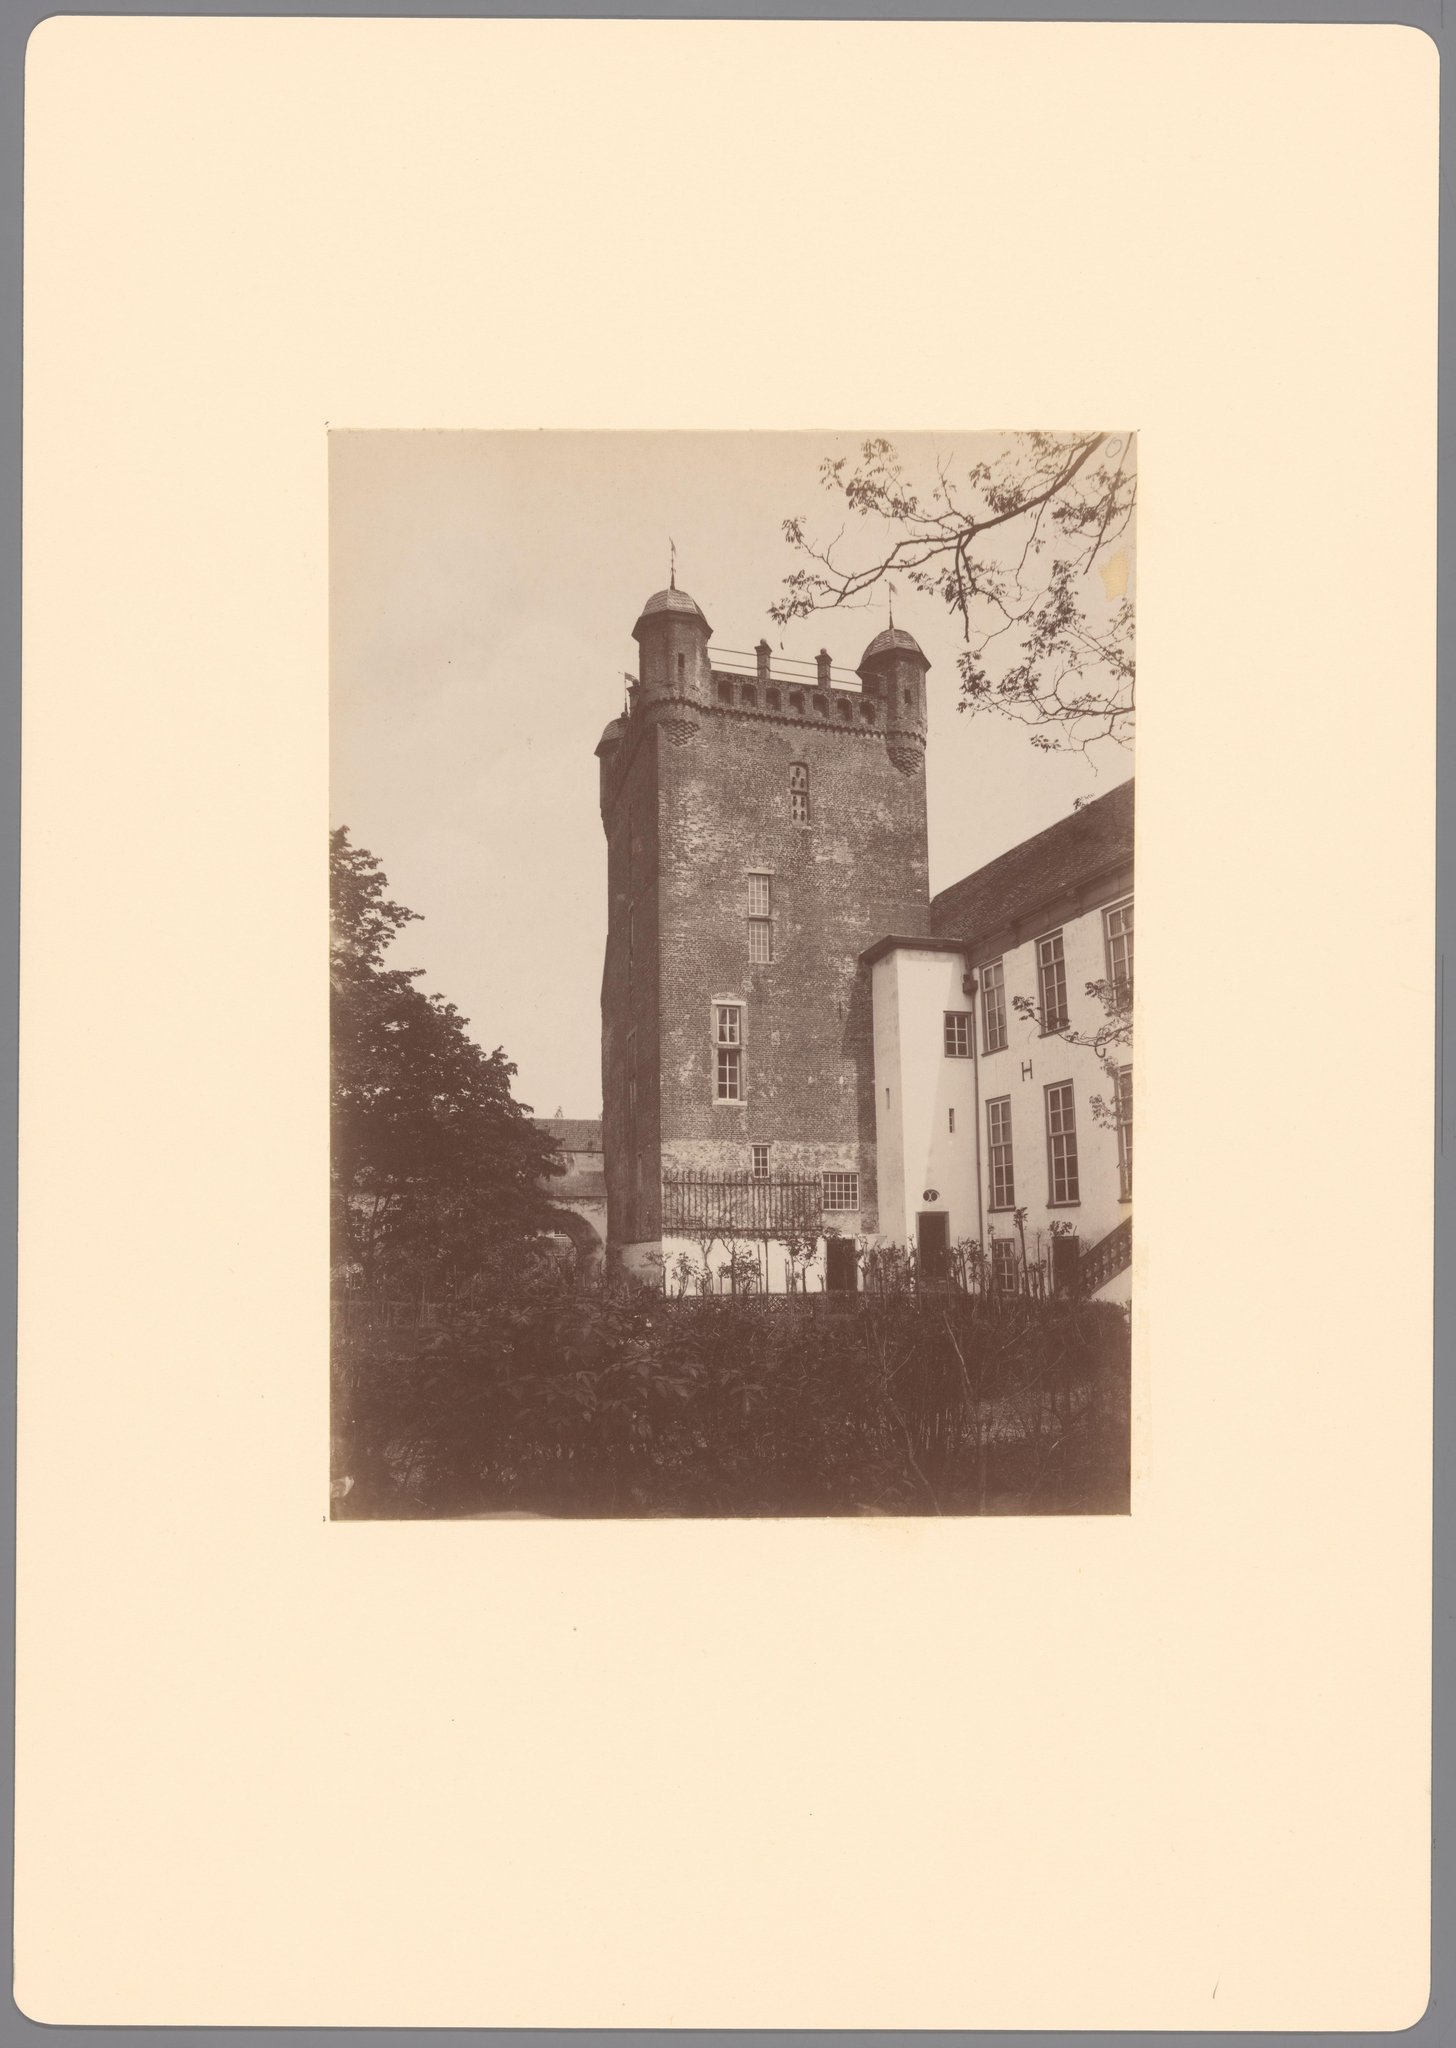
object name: photograph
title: Kasteeltoren van het Huis Bergh te 's Heerenberg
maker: anoniem (monumentenzorg)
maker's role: fotograaf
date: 1890-1920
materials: cardboard, photographic support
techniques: albumen print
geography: s-heerenberg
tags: castle, landscape with tower or castle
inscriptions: annotation: ‘Kasteel te 's Heerenberg’